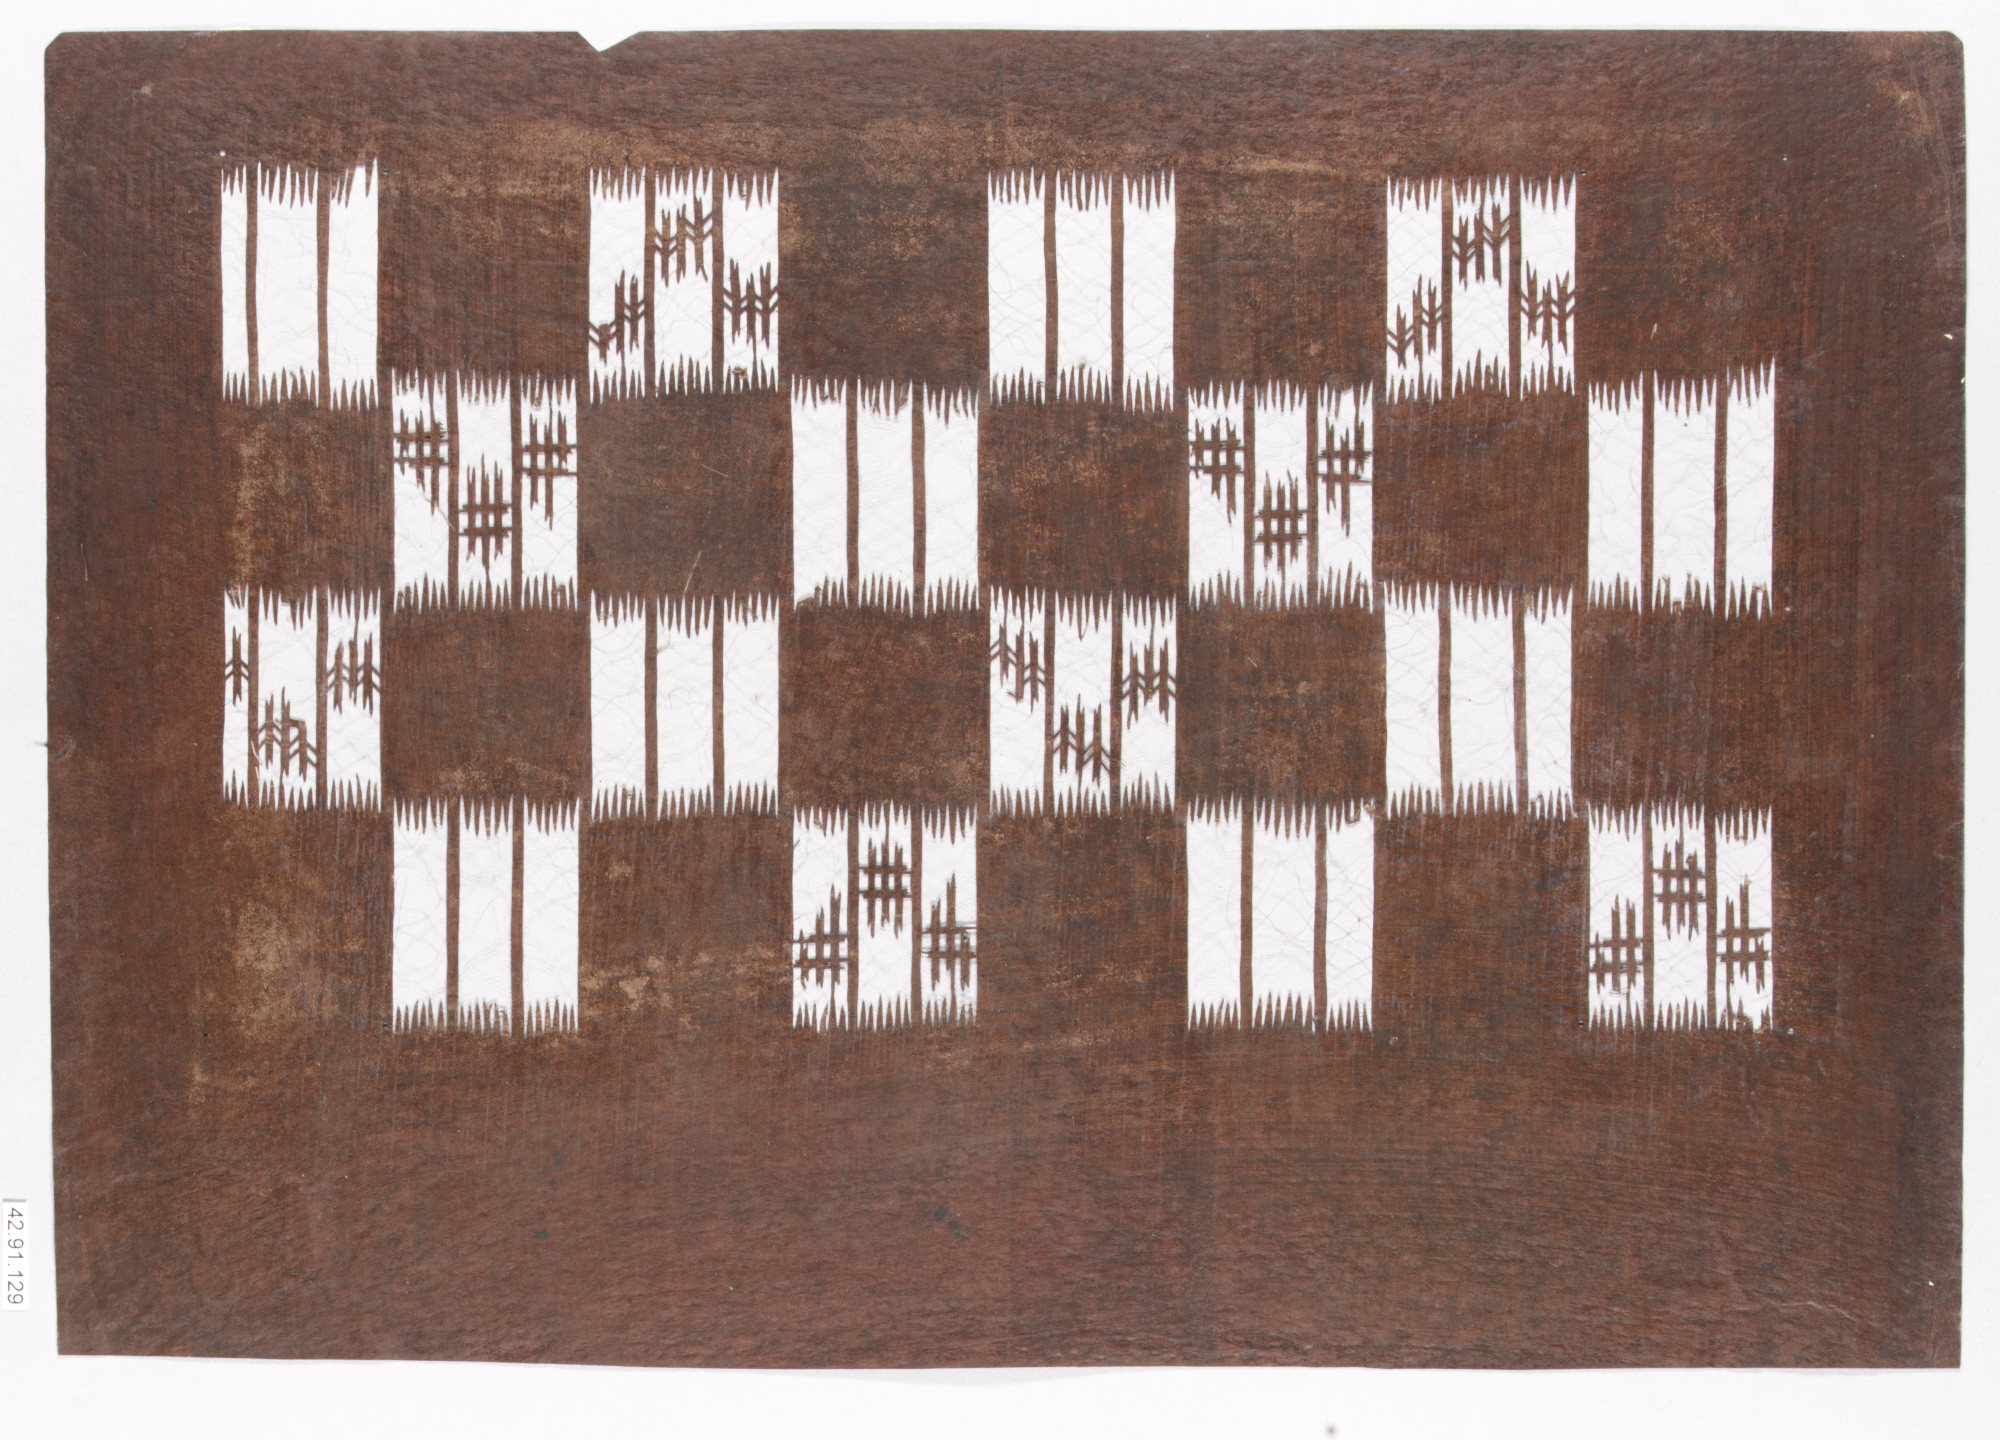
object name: stencil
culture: japanese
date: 1801-1900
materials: paper, silk